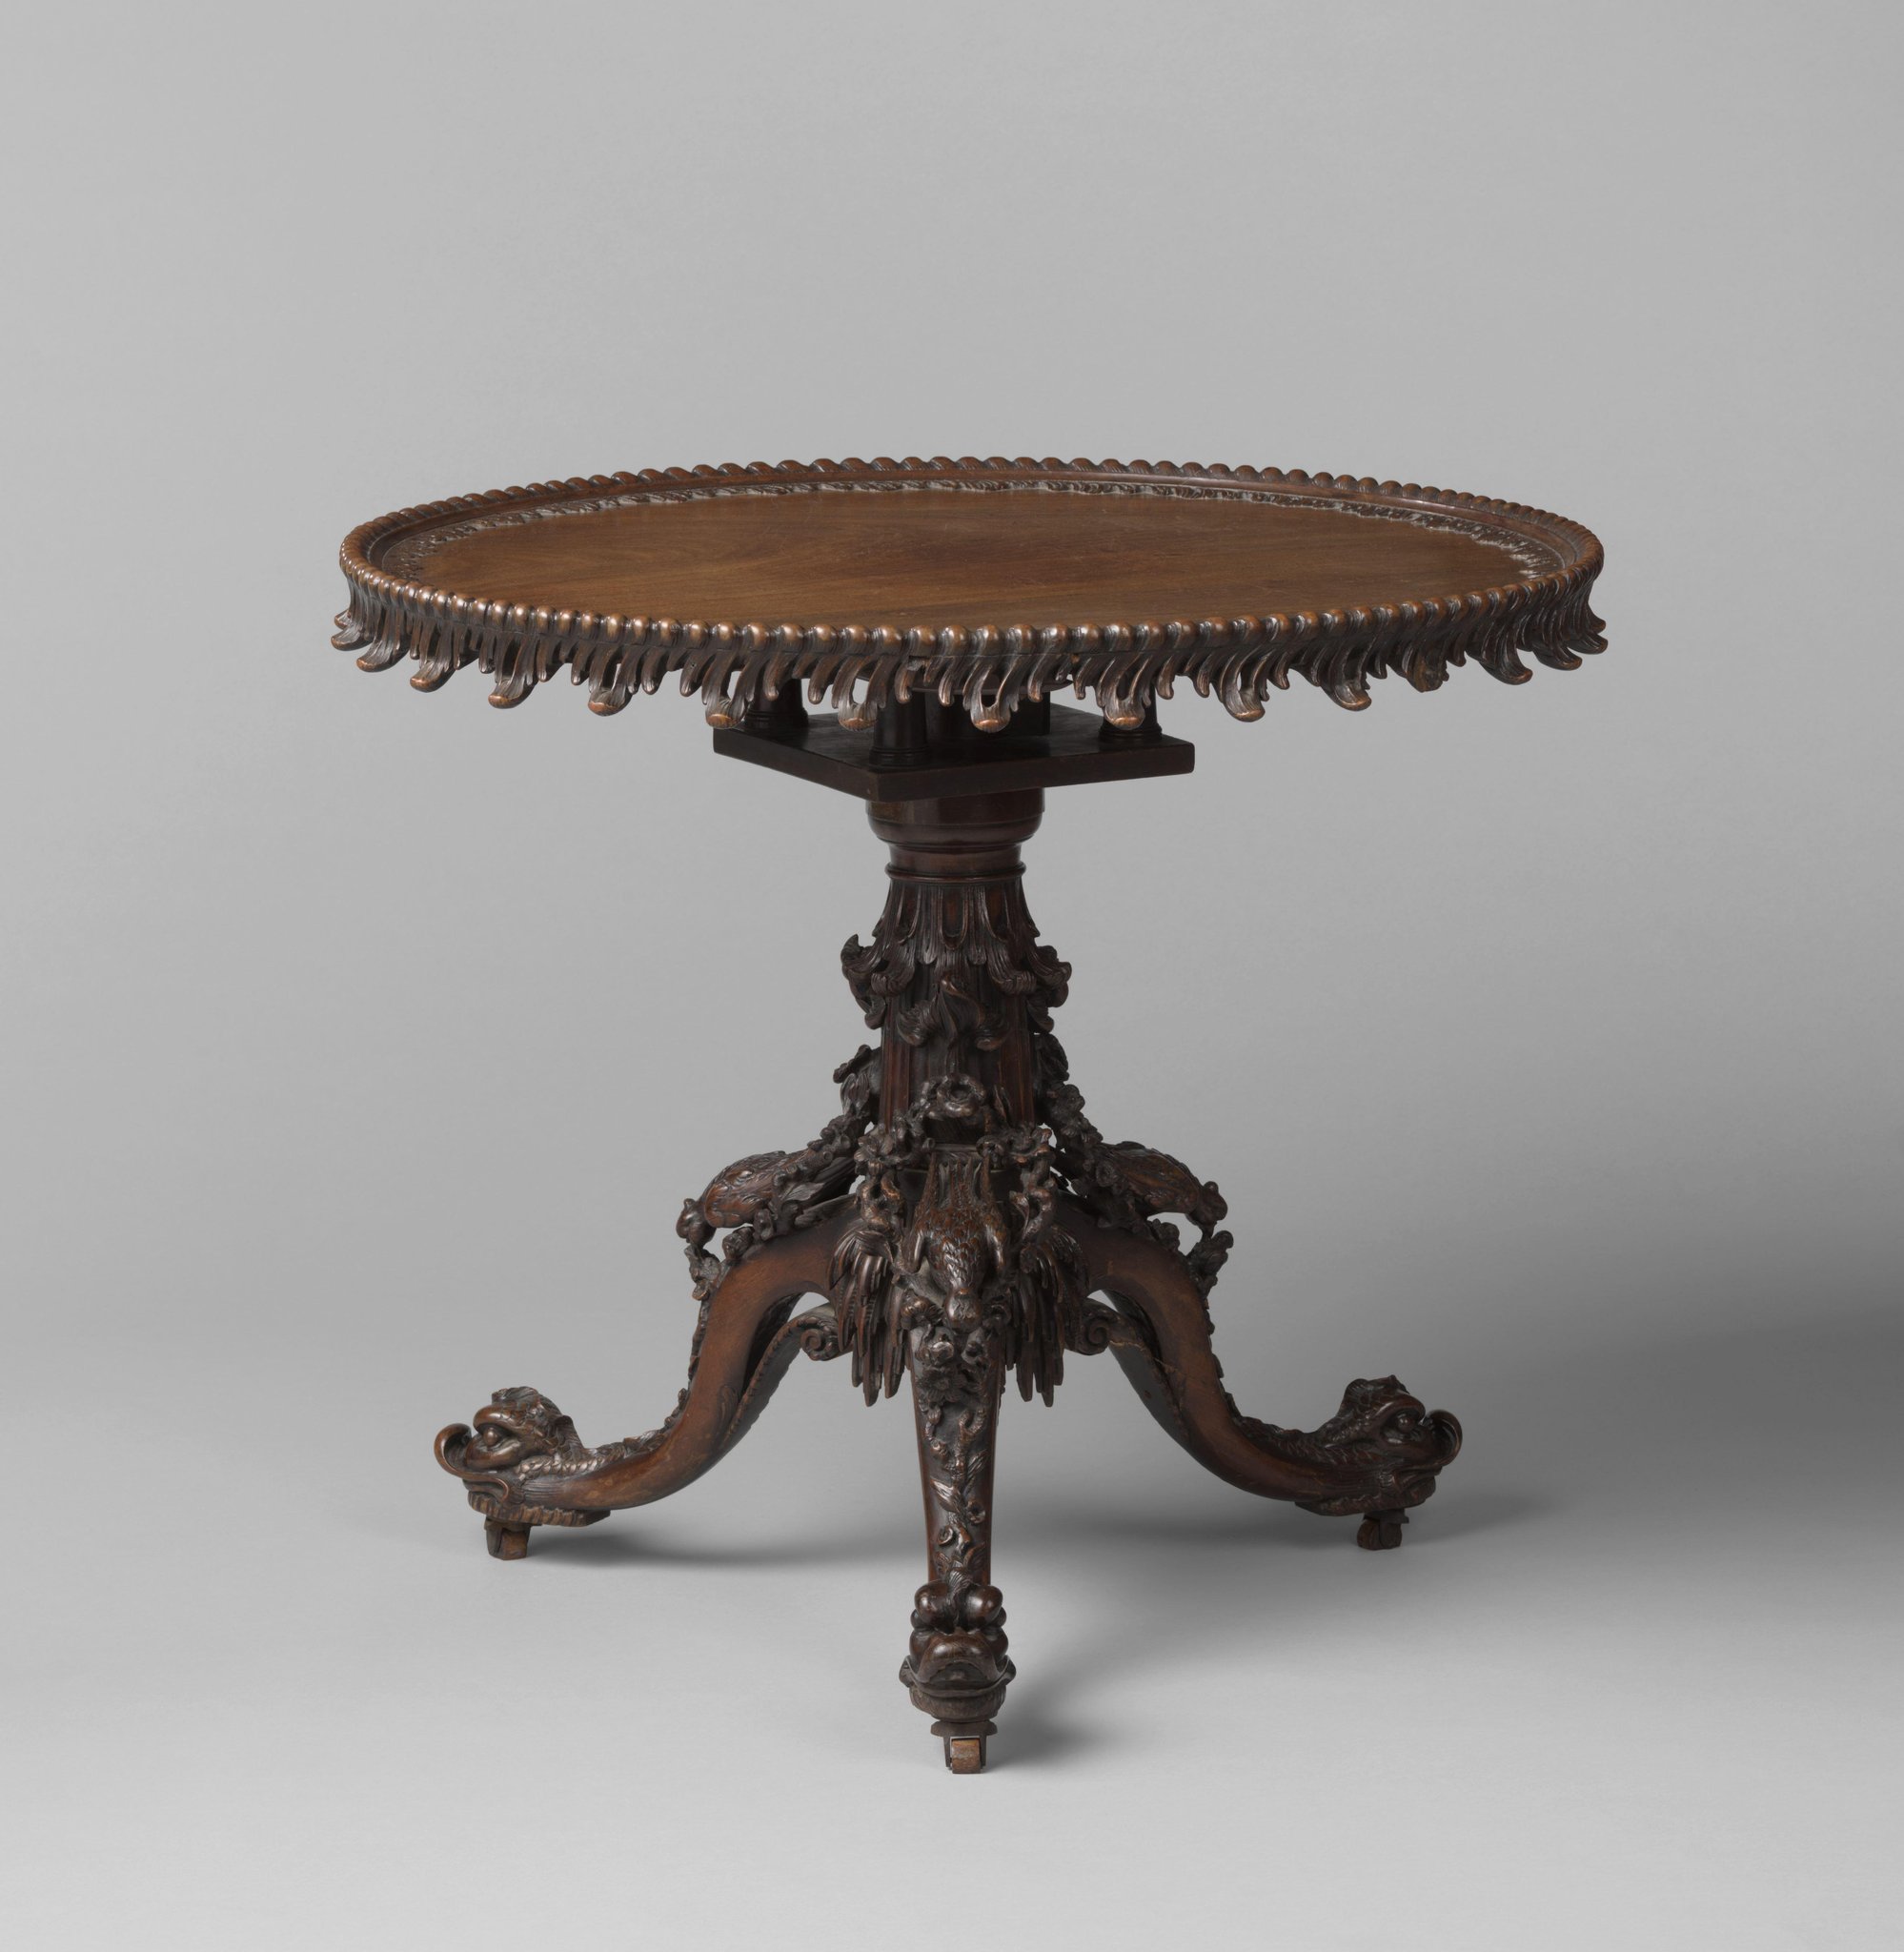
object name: table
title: Tafel met opklapbaar blad. Op de in drieën gesplitse poten pikkende vogels en drakenkoppen.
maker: Anonymous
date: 1700-1800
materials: wood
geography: great britain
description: Ronde mahoniehouten tafel, rustend op een schacht die zich in drie poten splitst, eindigend in gebeeldhouwde drakenkoppen. Op deze poten zijn gebeeldhouwde vogels aangebracht, die aan afhangende guirlandes pikken. De rand van het opklapbare blad is versierd met een afhangend gebeeldhouwd bladmotief.